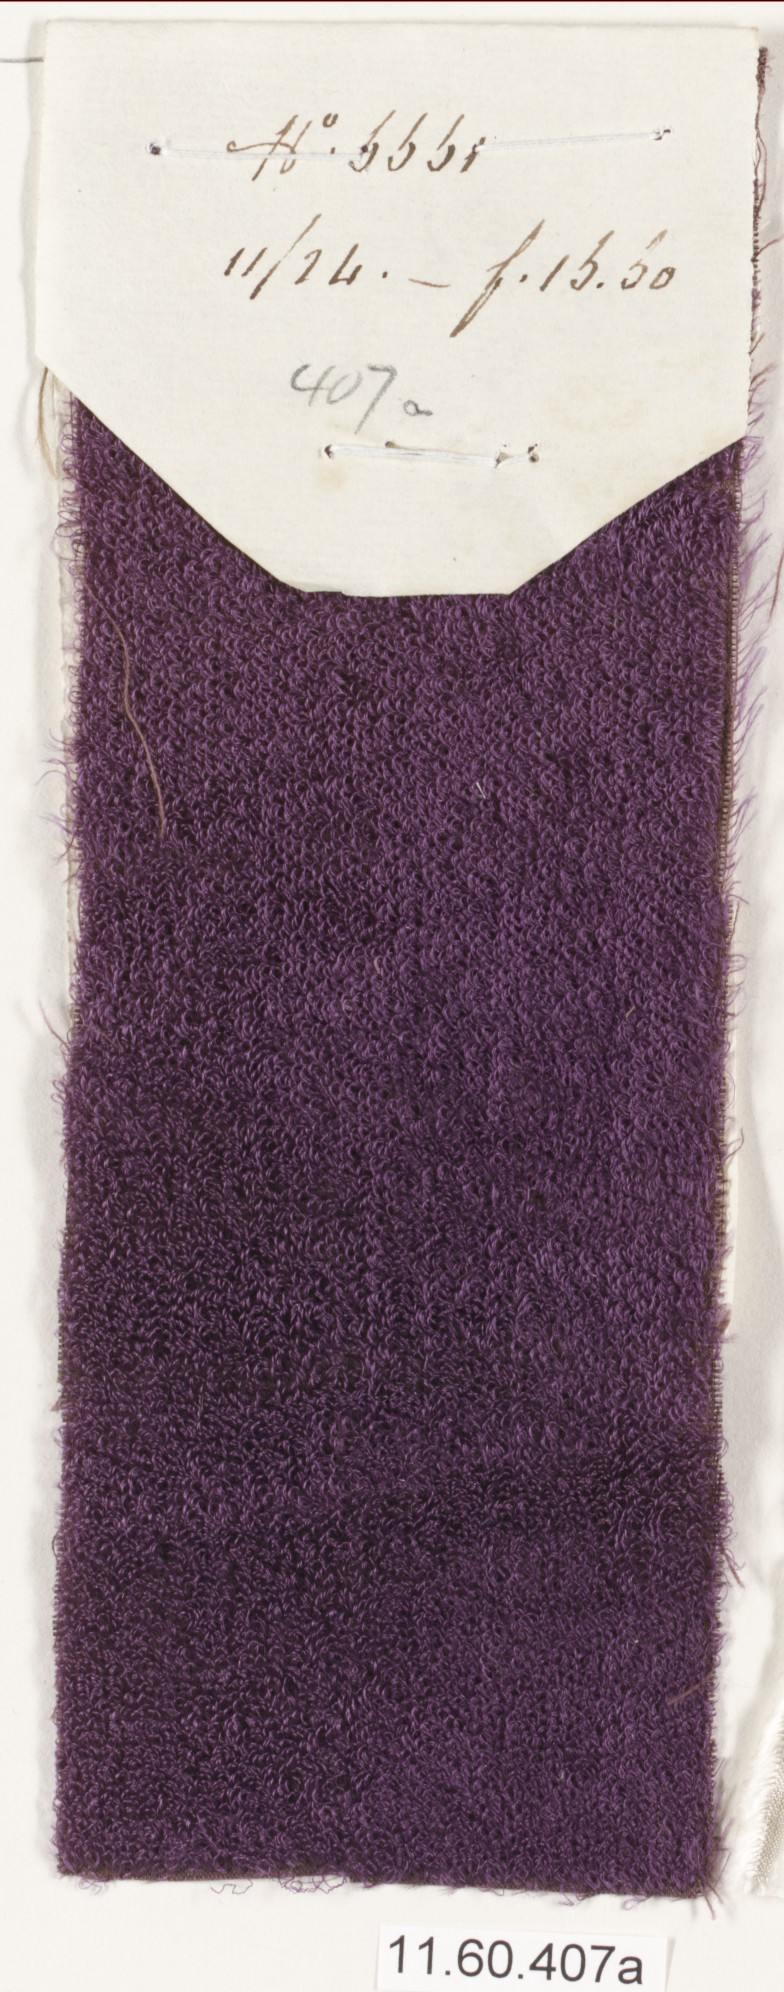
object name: fragment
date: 1801-1900